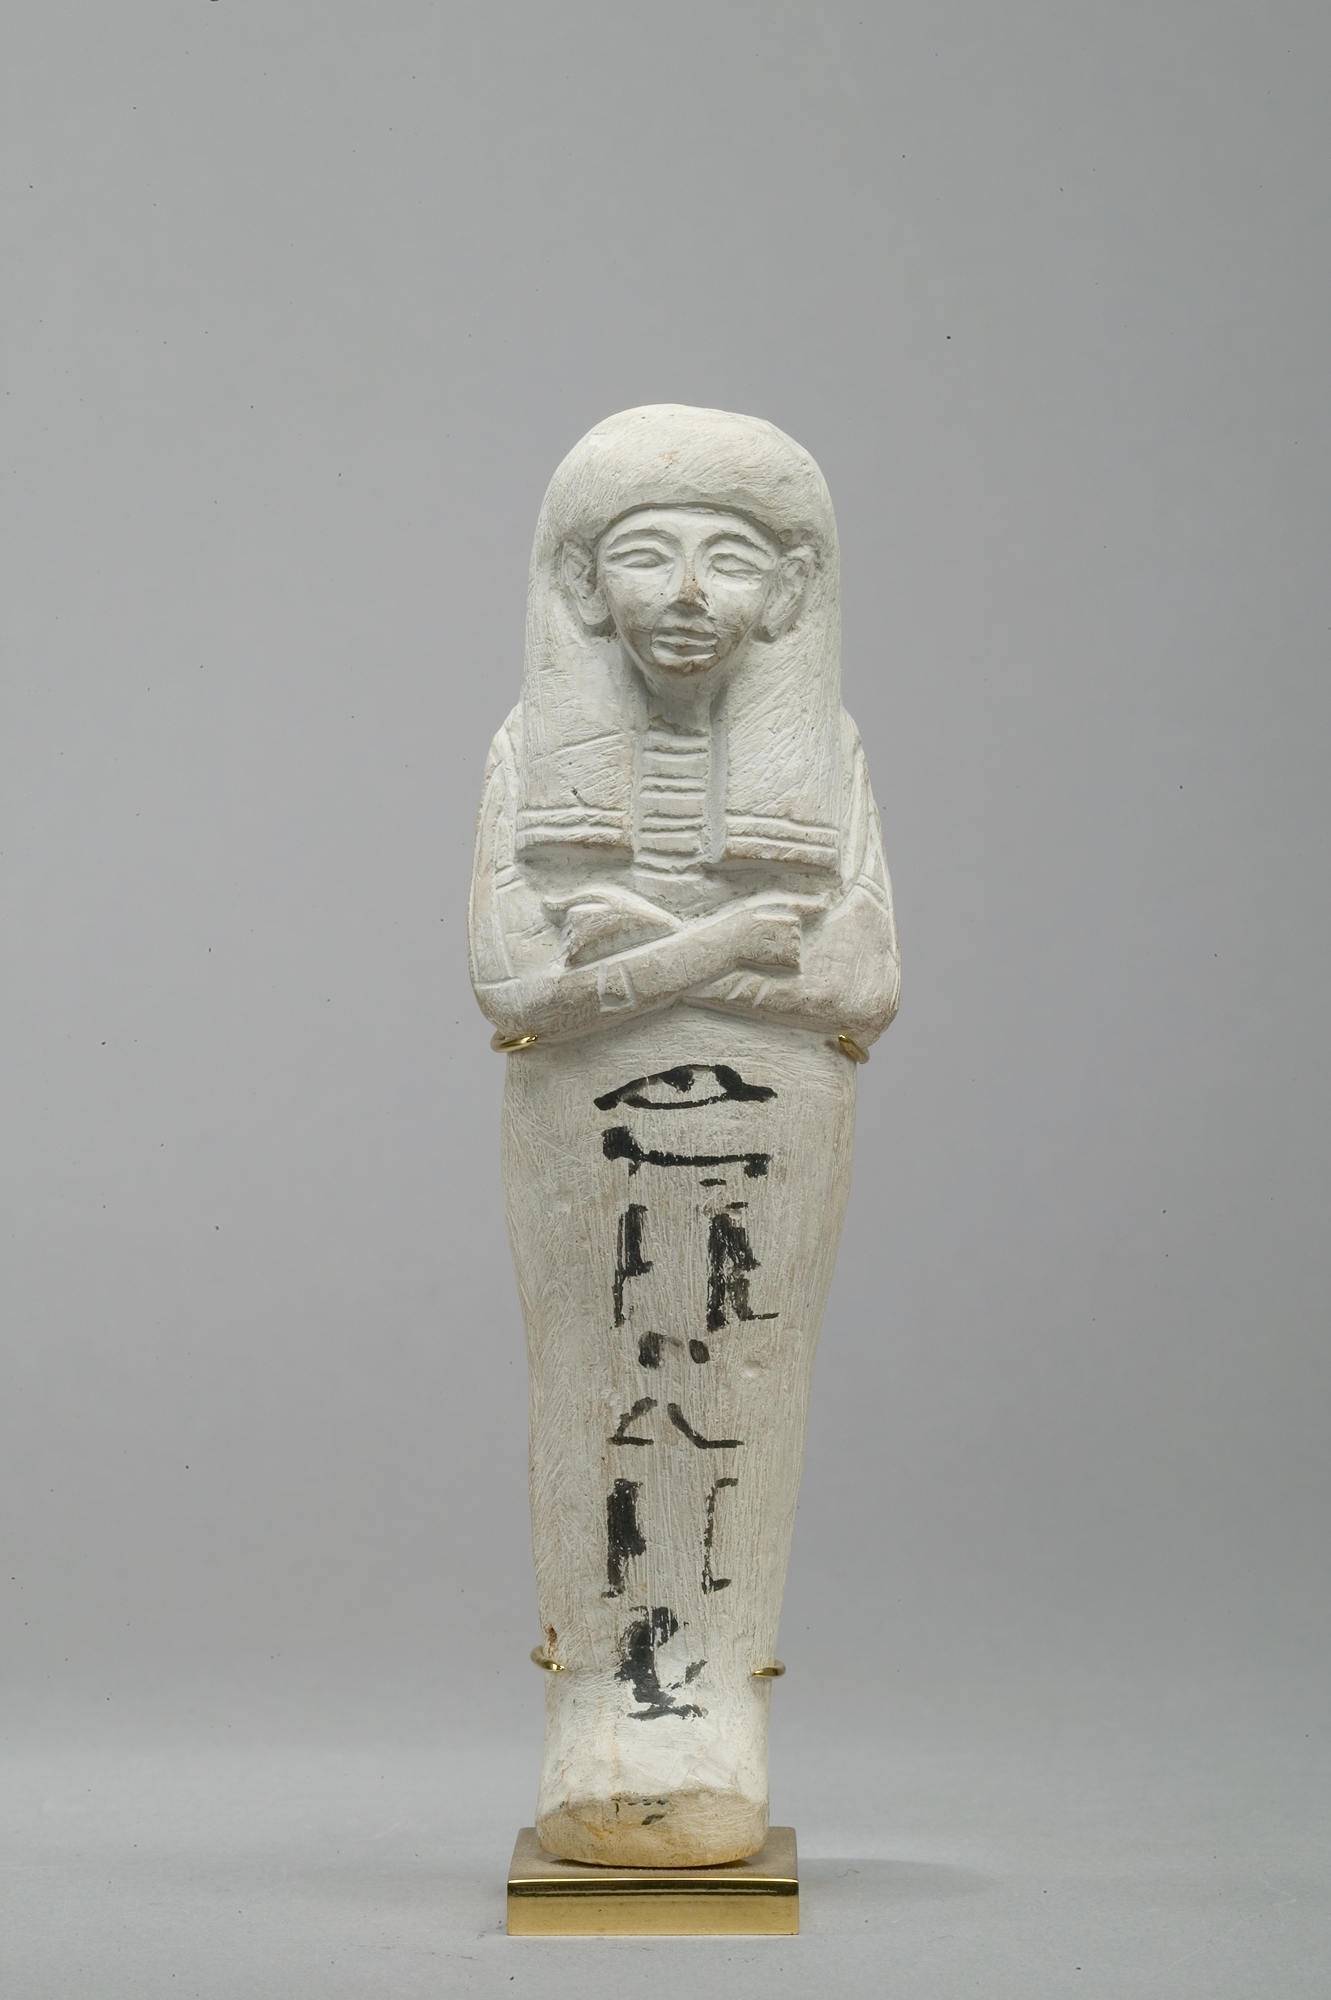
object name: shabti, ity iineferty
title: Shabti of Ity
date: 1279-1213 BCE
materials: limestone, paint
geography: egypt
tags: hieroglyphs